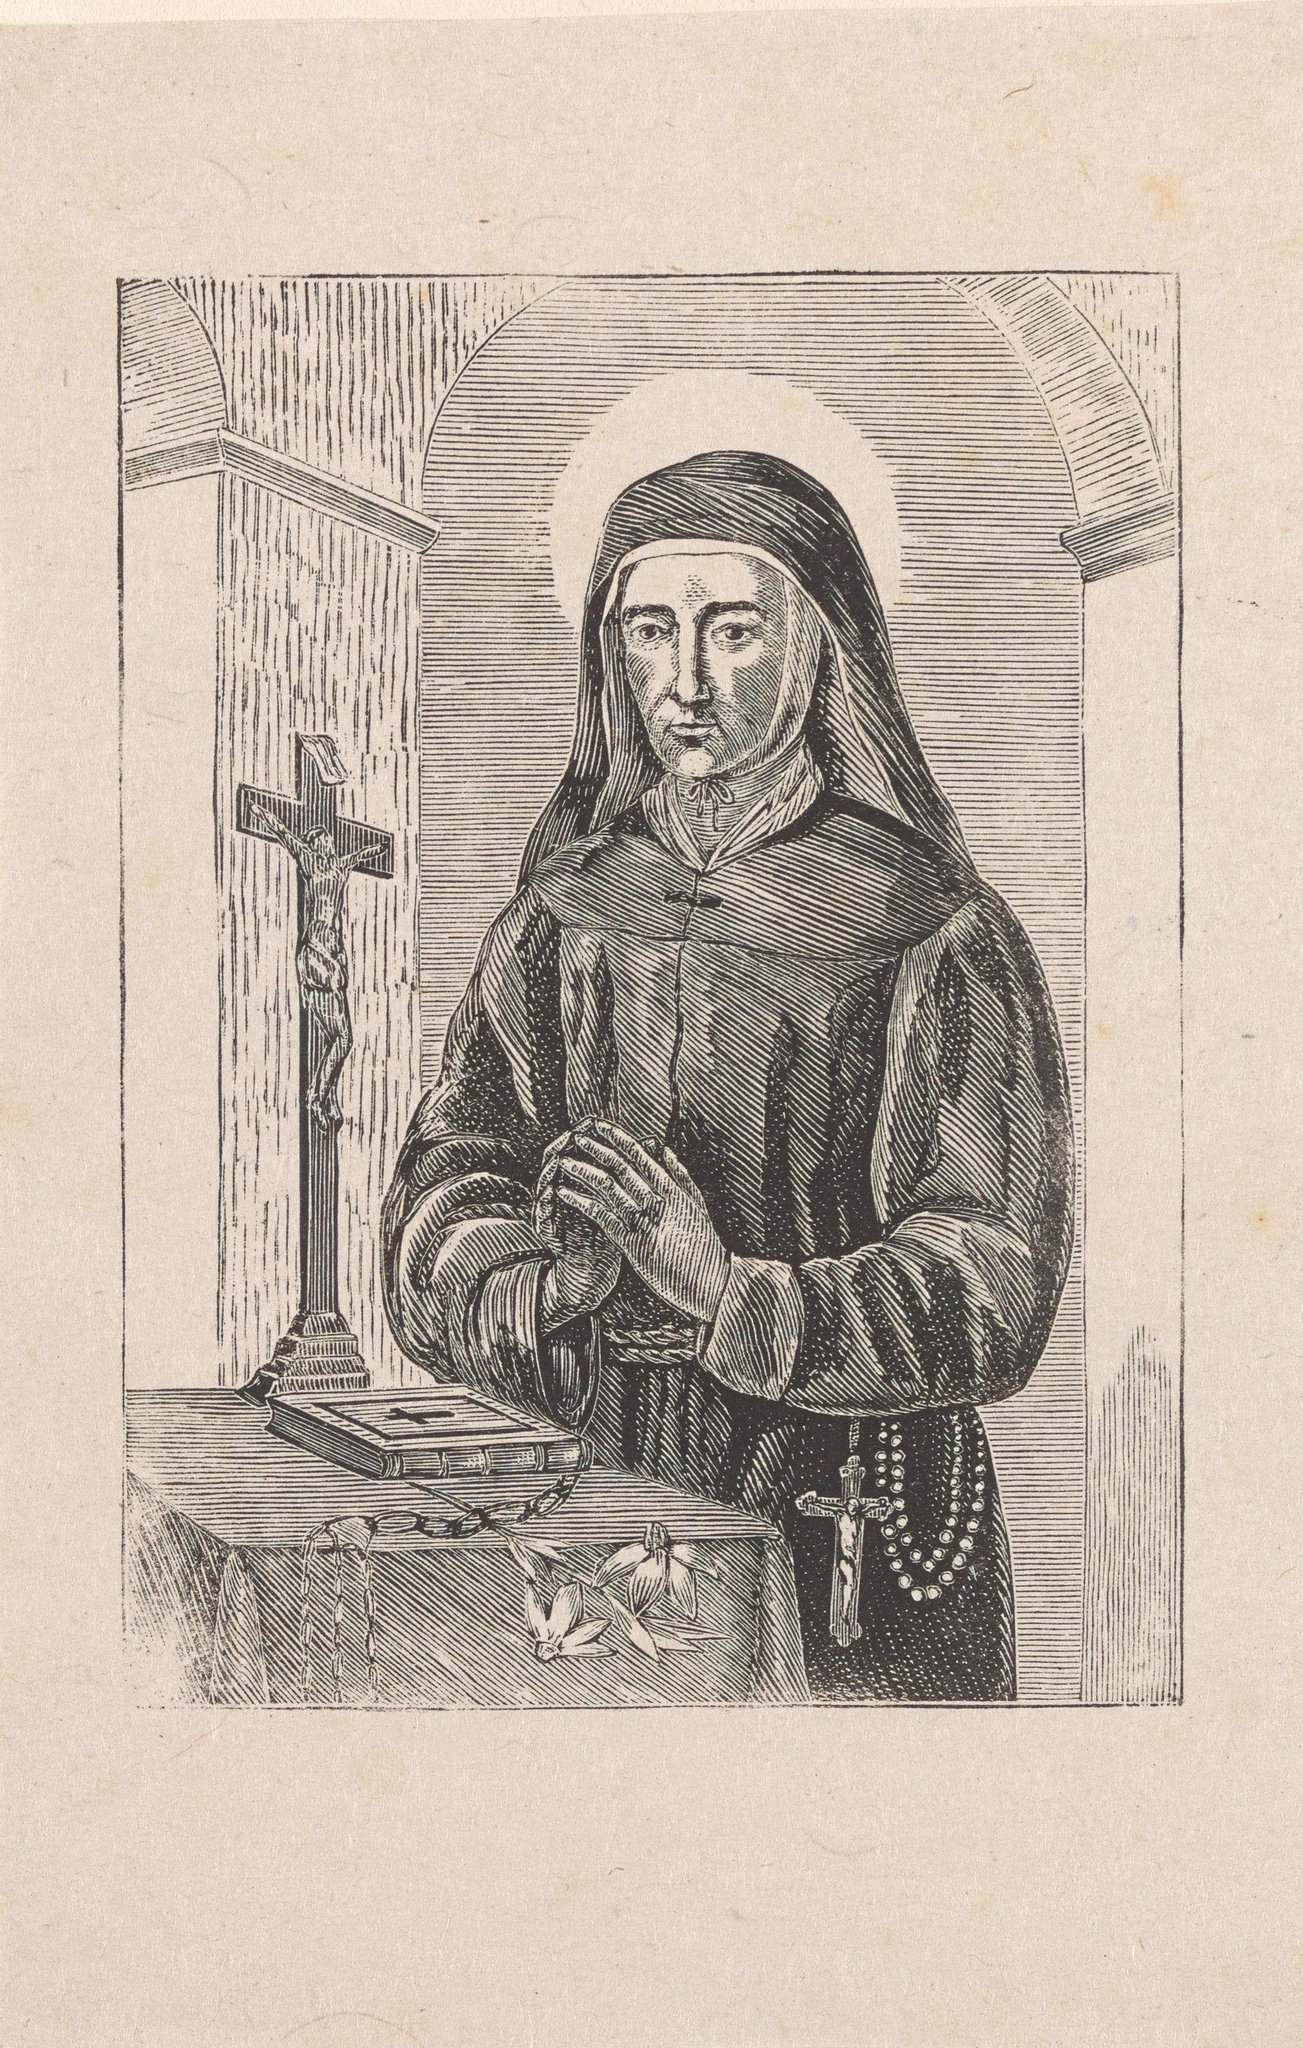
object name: print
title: Heilige met een crucifix, een bijbel en een bloem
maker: isaac weissenbruch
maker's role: print maker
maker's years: 1826-1912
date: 1836-1912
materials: paper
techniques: engraving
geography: netherlands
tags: flowers, altarcross, crucifix, saints, the bible as a book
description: Heilige met een crucifix, een bijbel en een bloem, mogelijk Maria Francisca van de Vijf Wonden van Jezus